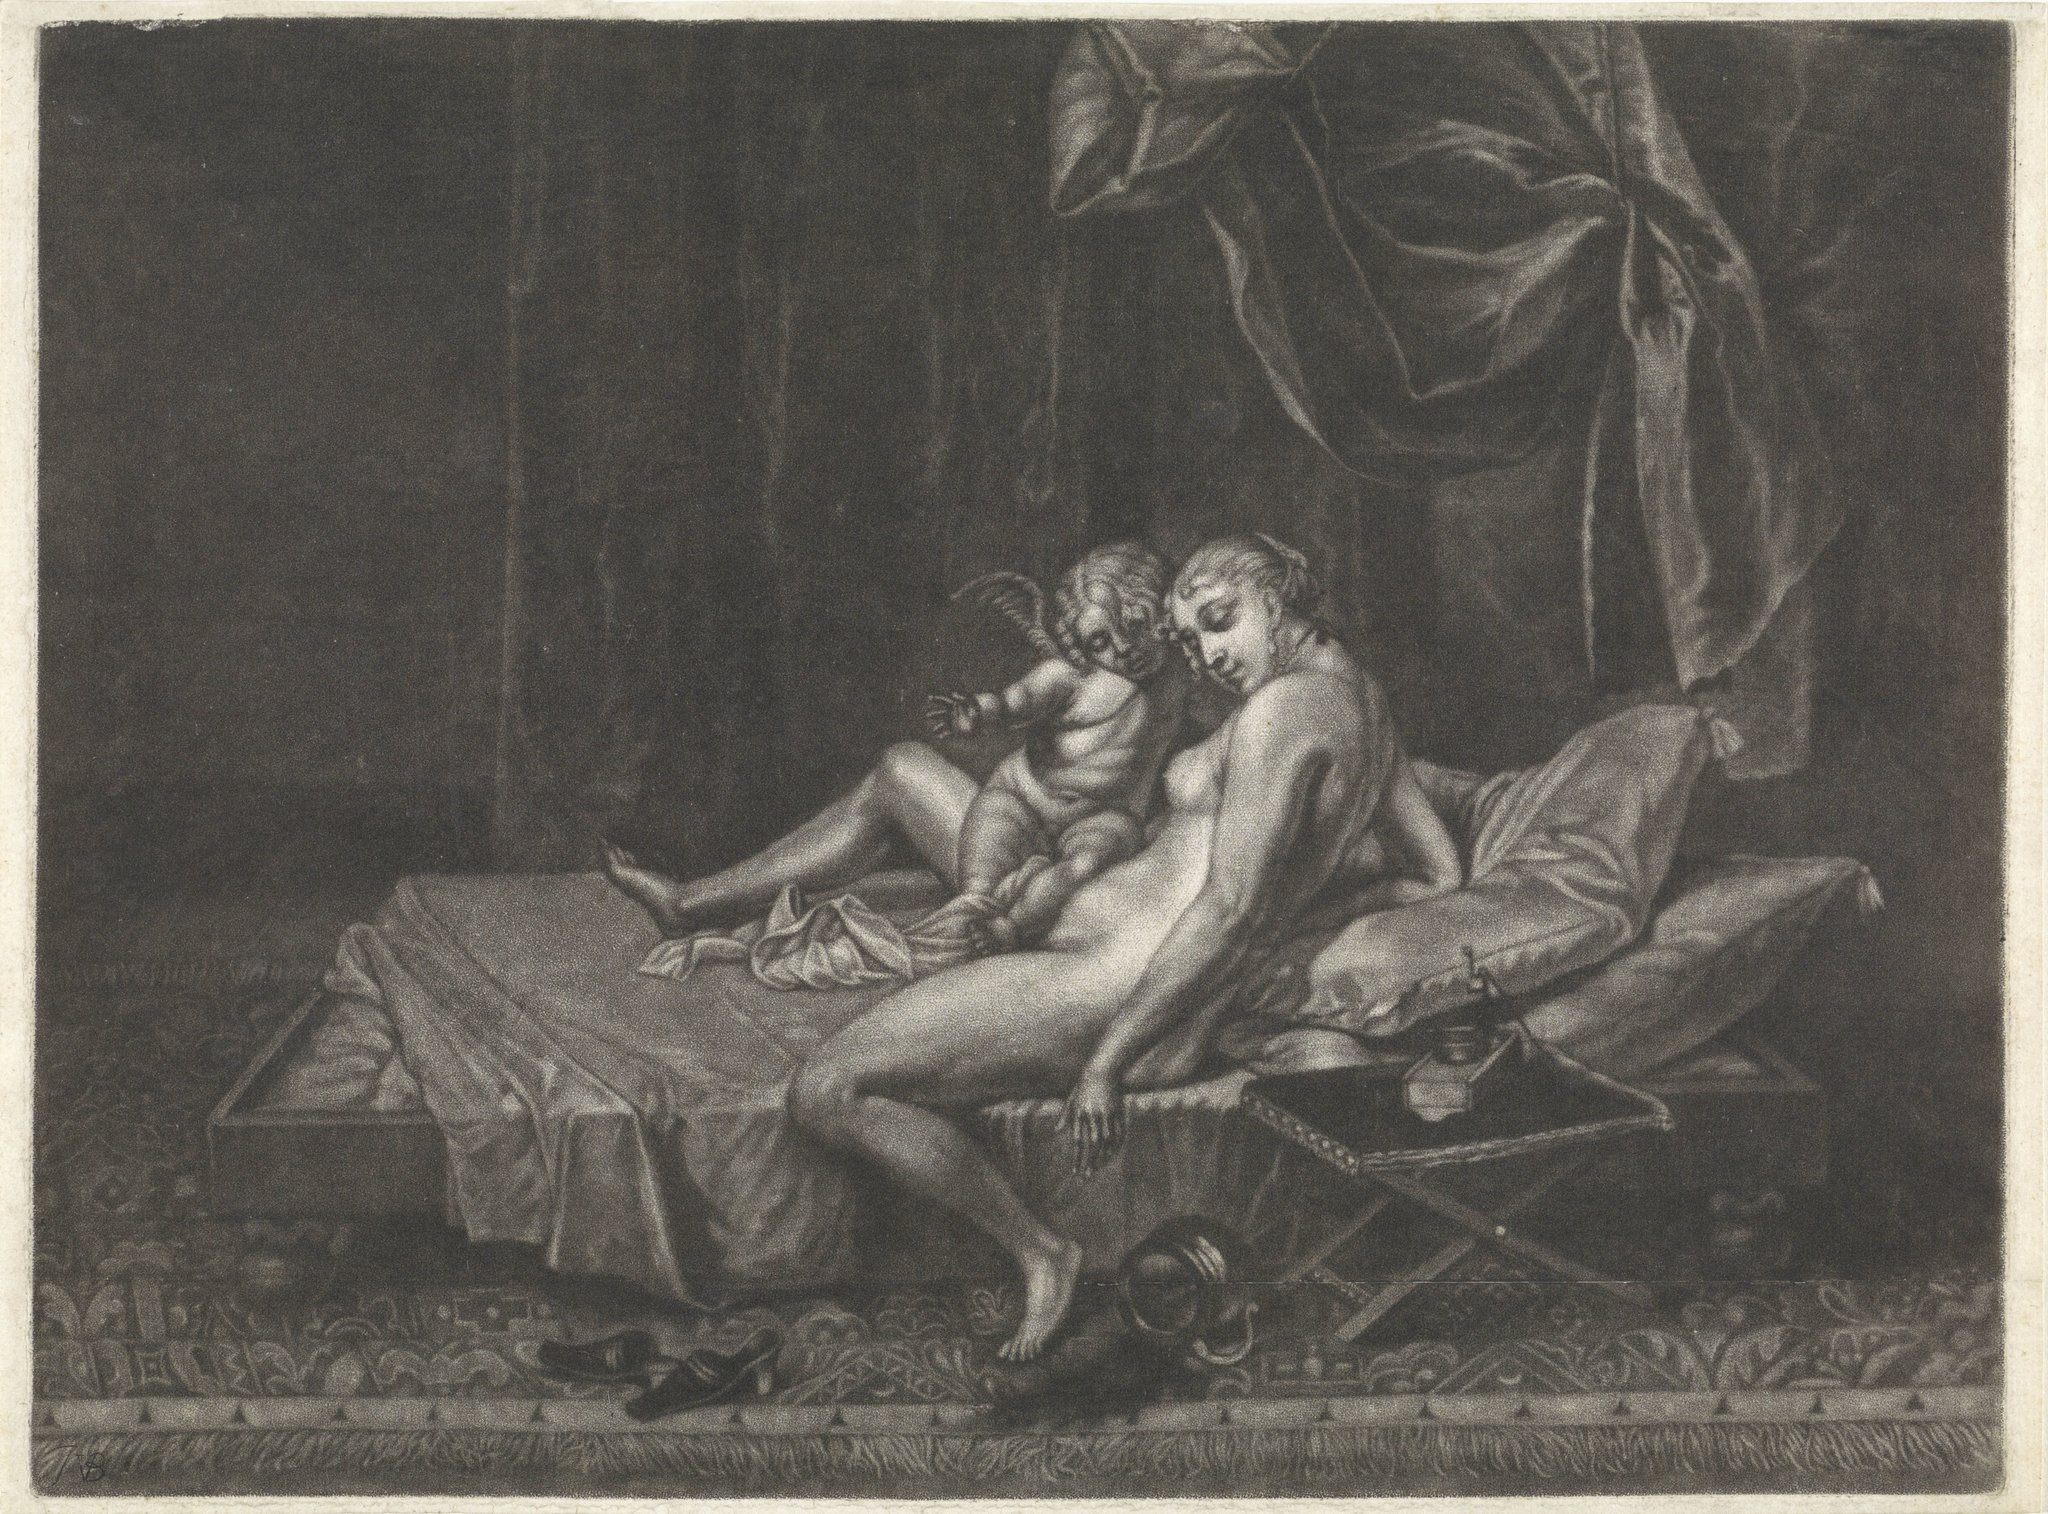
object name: print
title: Venus en Amor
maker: jan van der bruggen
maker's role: draughtsman, print maker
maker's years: 1649-1709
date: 1659-1740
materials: paper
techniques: engraving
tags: venus and cupid (cupid not being mere attribute)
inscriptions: collector's mark: Lugt 2228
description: Venus en Amor liggen in bed onder een baldakijn. Naast het bed een omgevallen po.